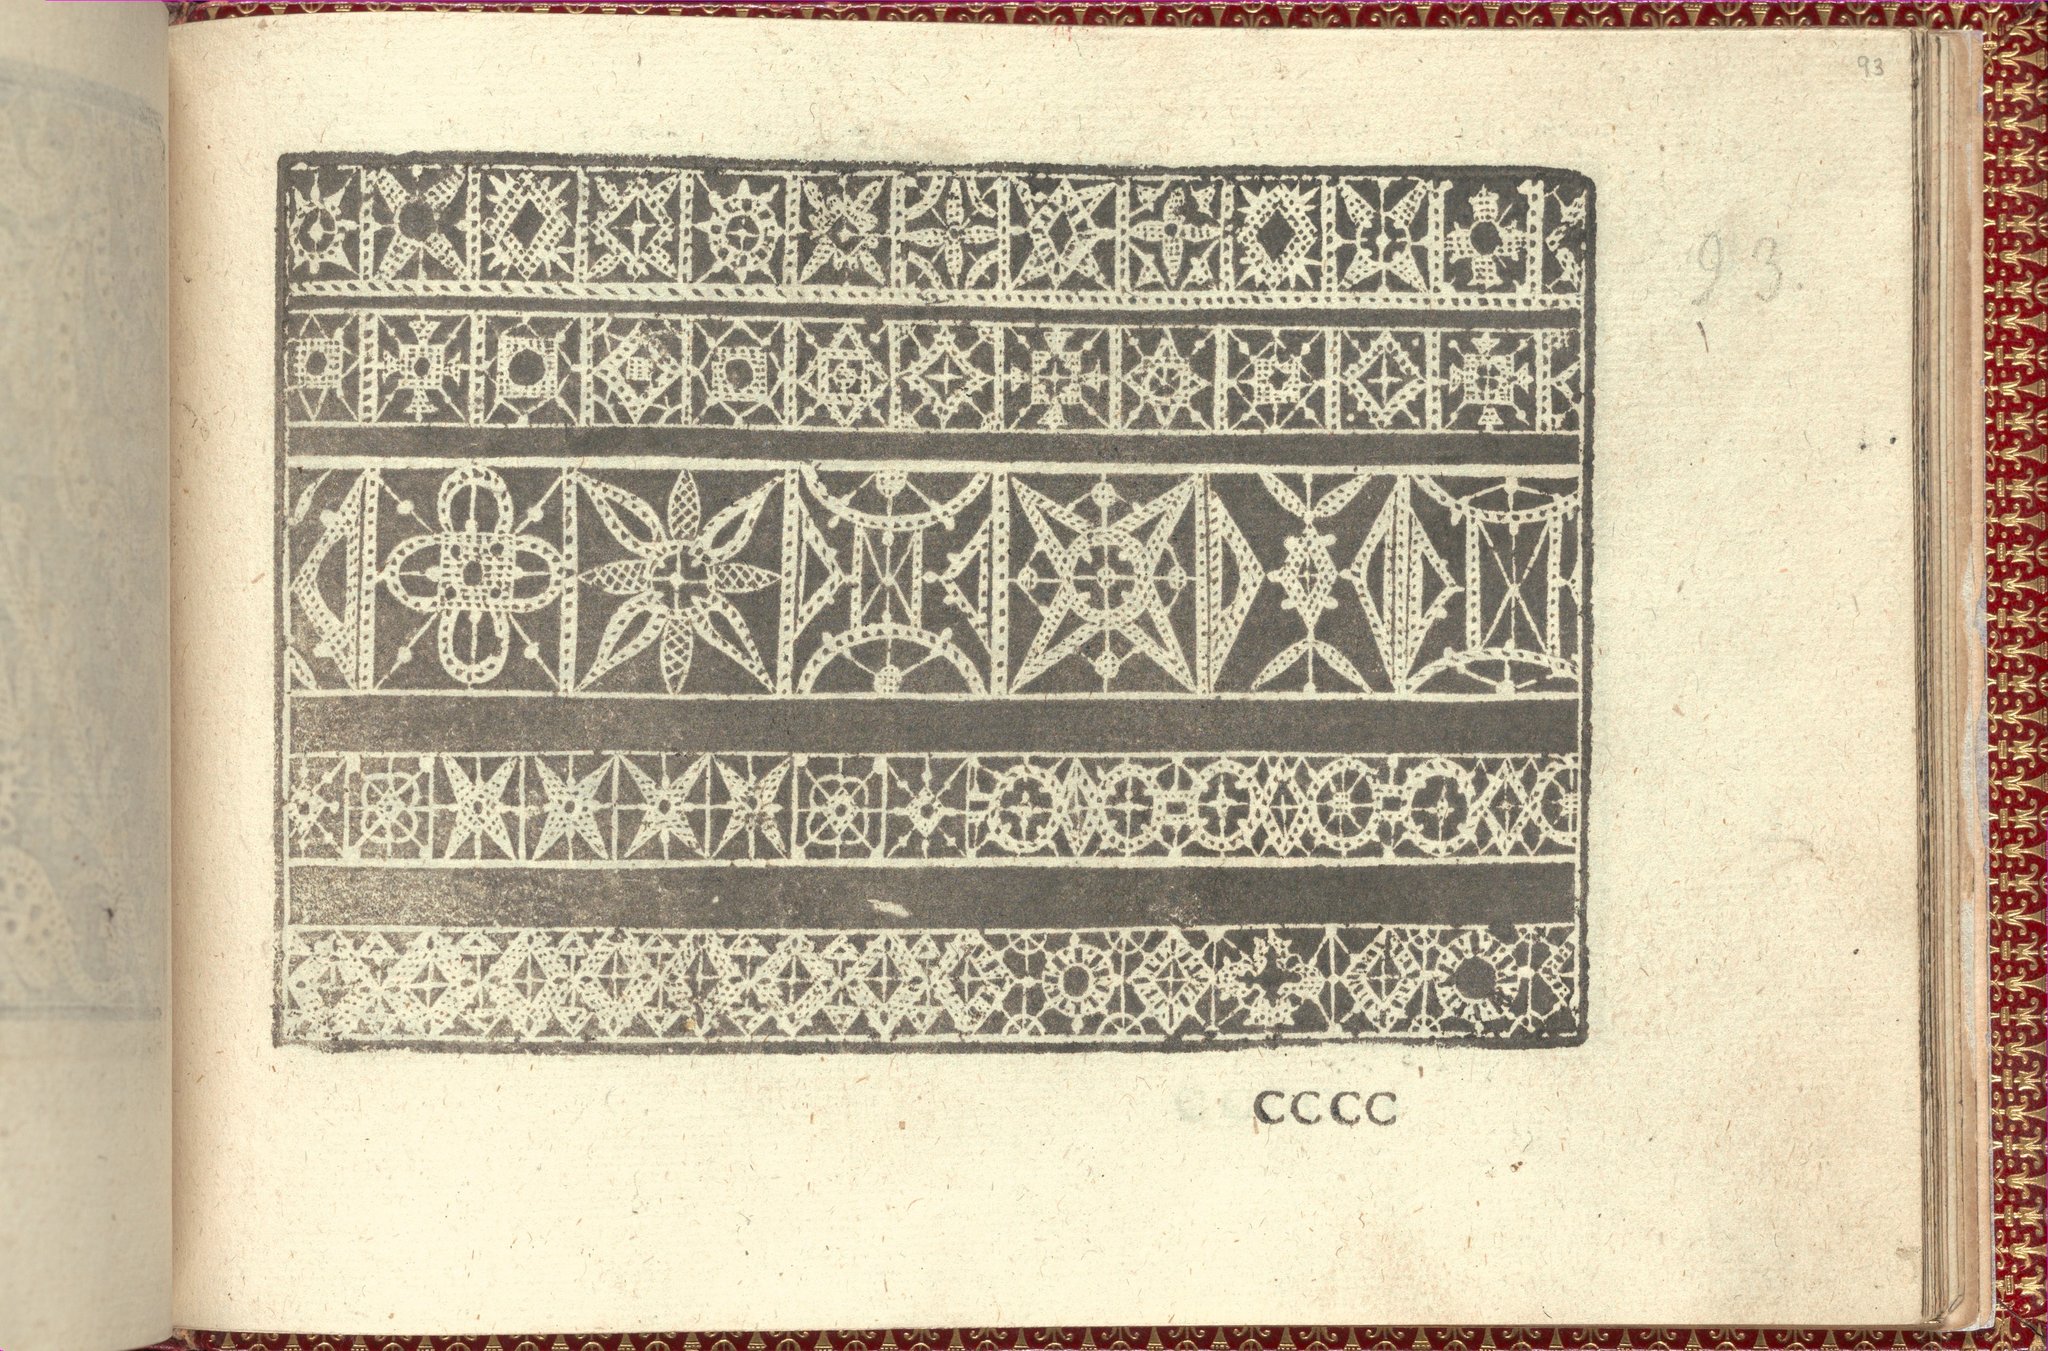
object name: book print ornament architecture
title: Corona delle Nobili et Virtuose Donne: Libro I-IV, page 93 (recto)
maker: cesare vecellio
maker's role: publisher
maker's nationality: italian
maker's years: 1521-1601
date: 1601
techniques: woodcut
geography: italy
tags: ornament